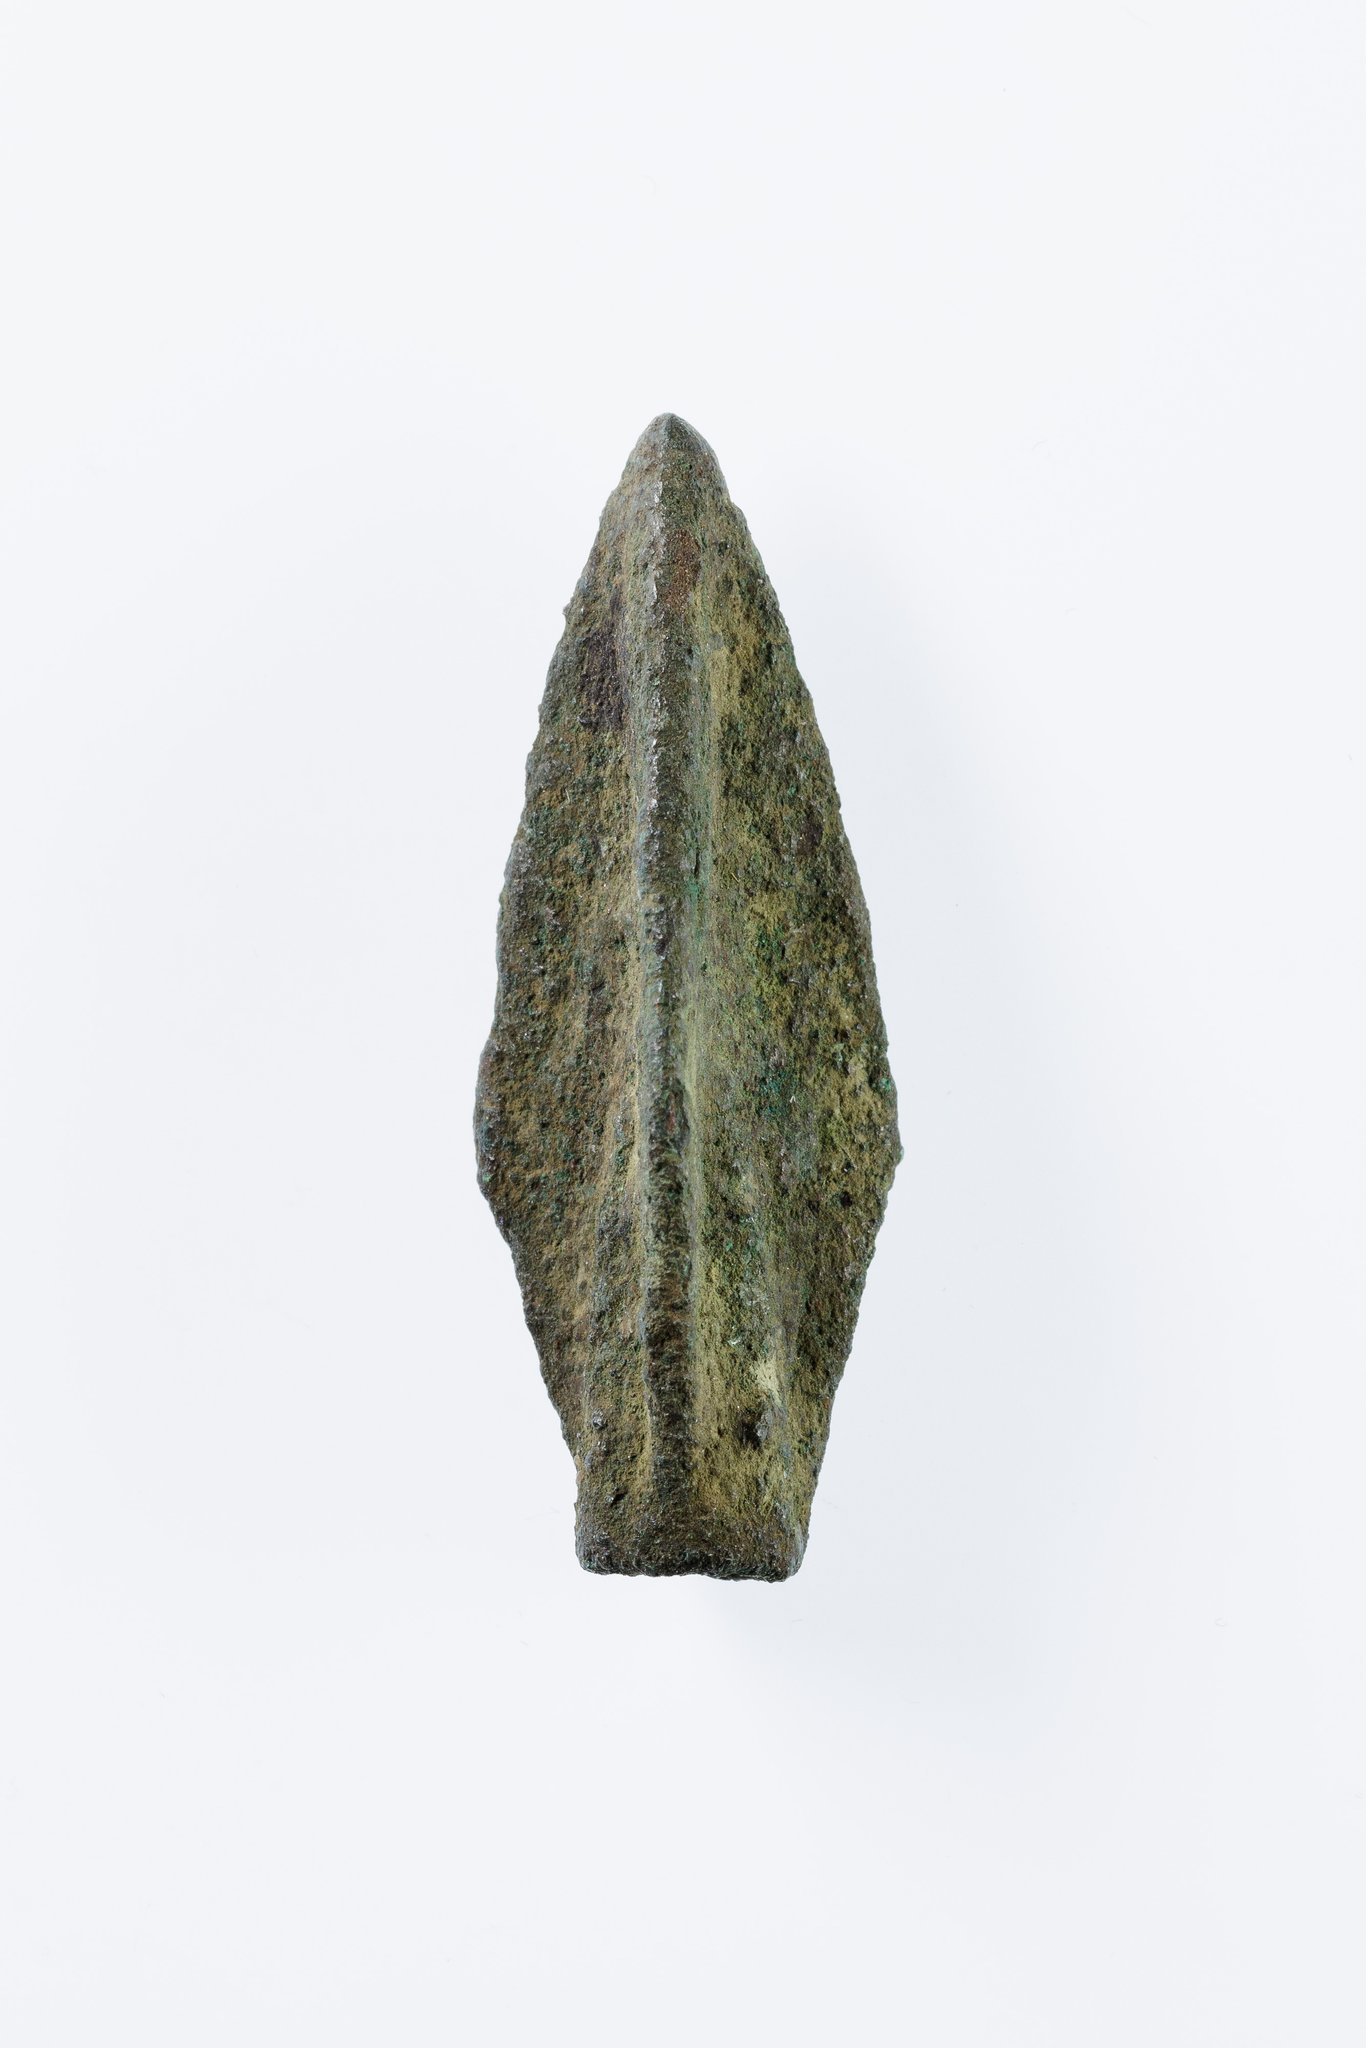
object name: arrow point, apries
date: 589-570 BCE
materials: bronze, copper alloy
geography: egypt